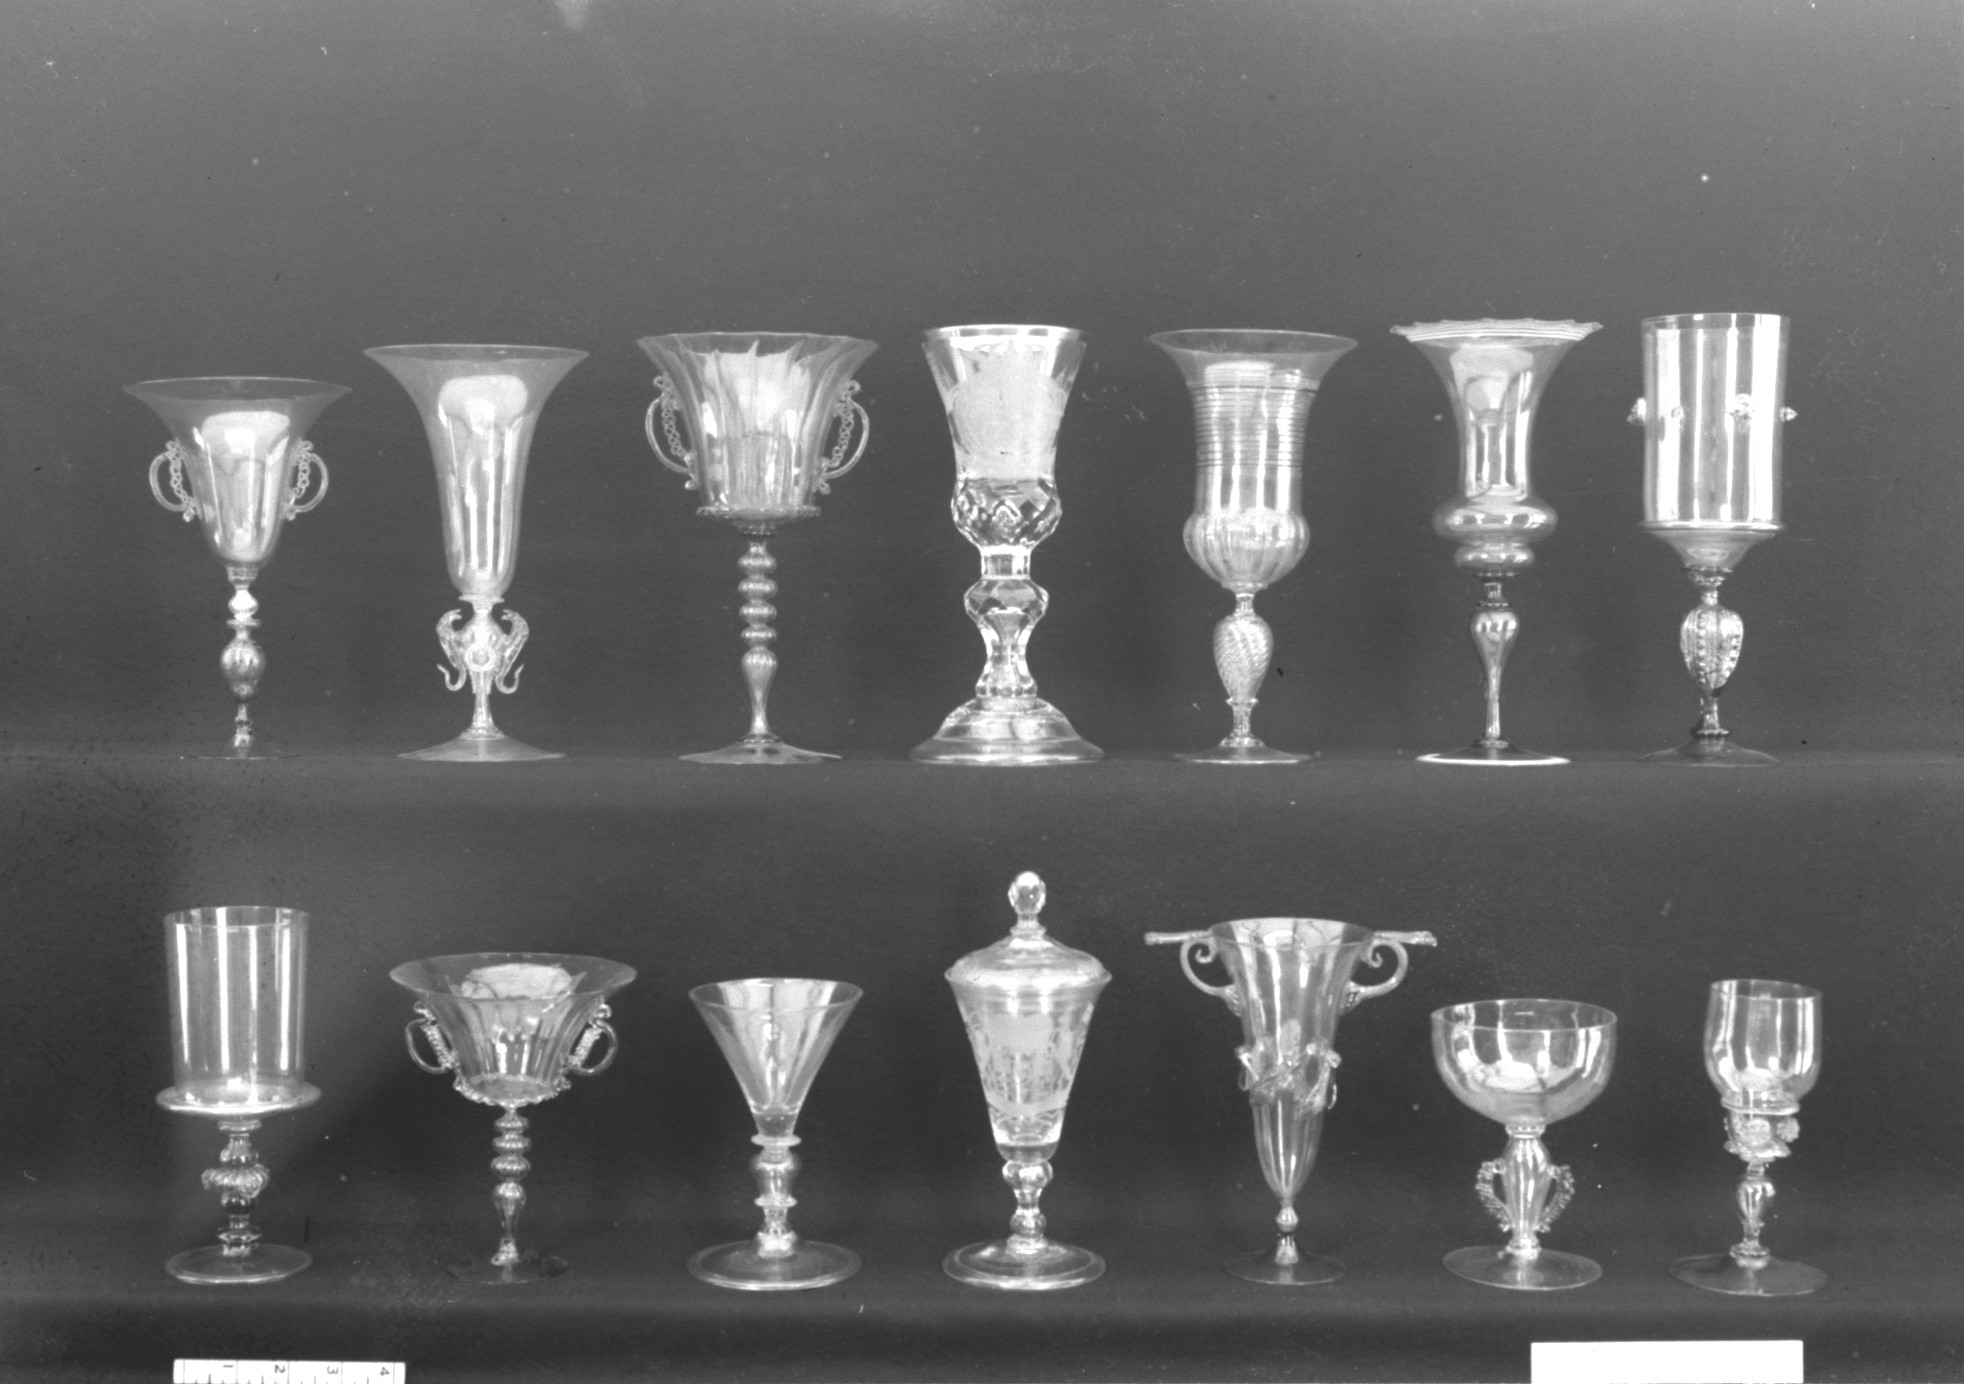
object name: wineglass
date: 1801-1900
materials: glass